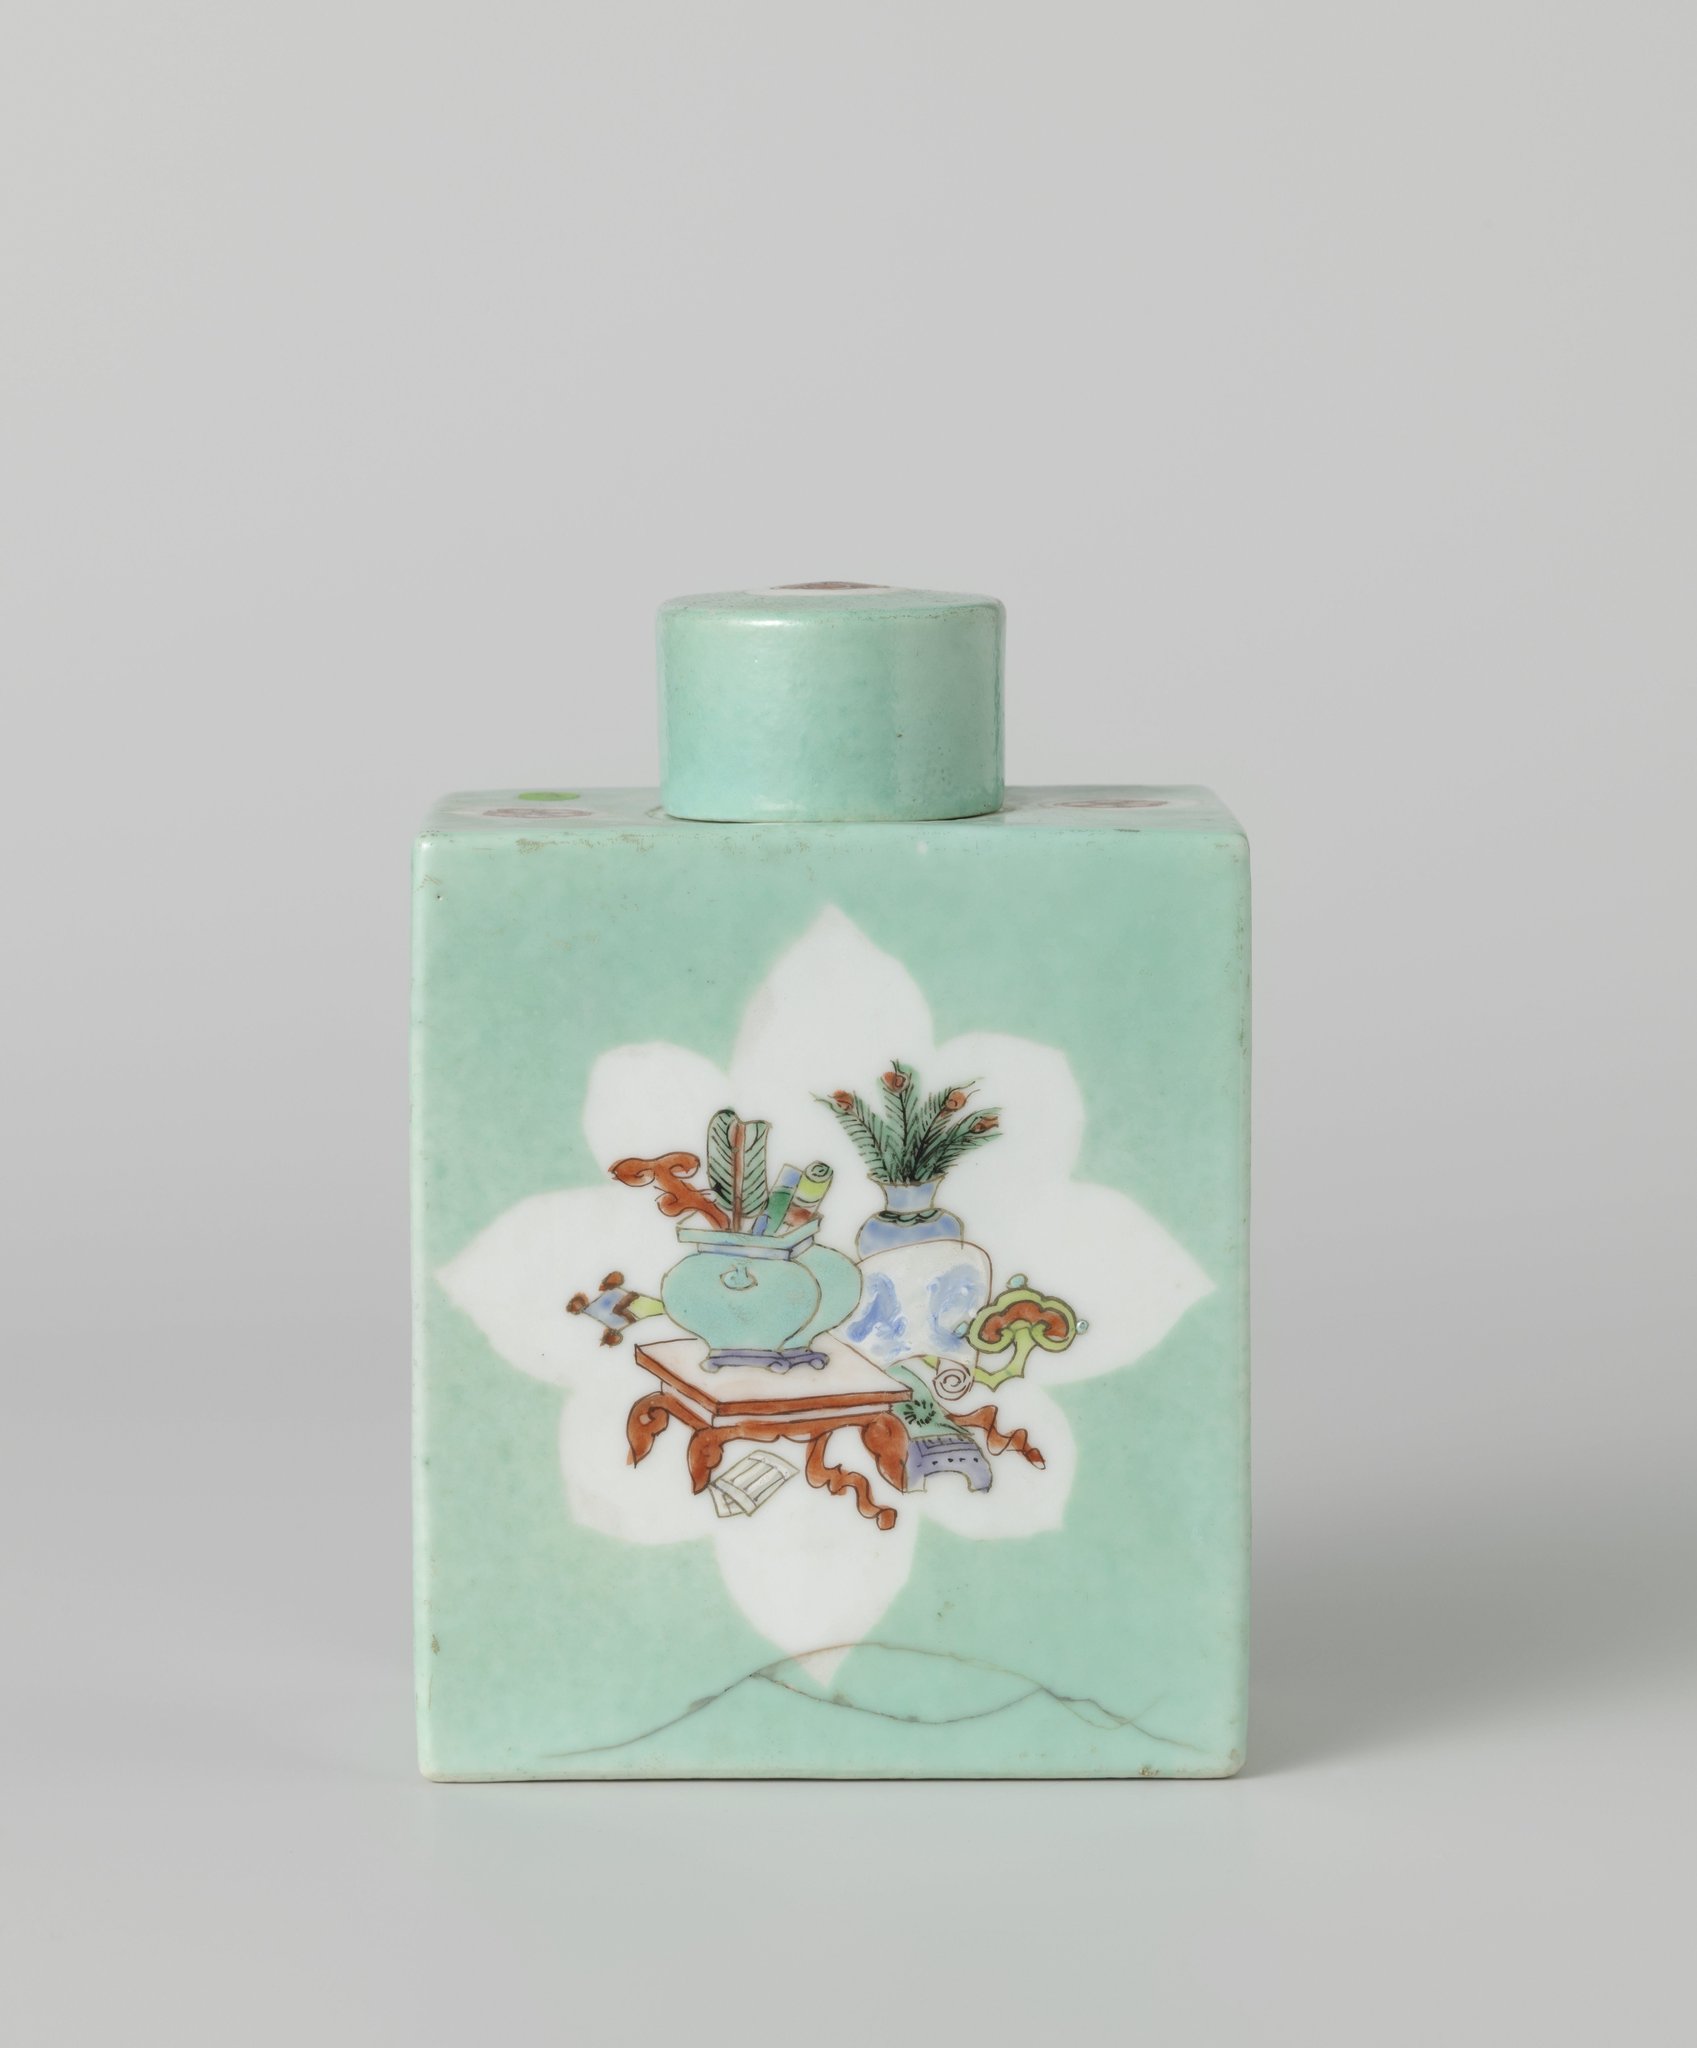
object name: lid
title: Rectangular tea caddy covered with a light blue glaze and antiquities in panels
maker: Anonymous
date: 1760-1770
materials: glaze, paint, porcelain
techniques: firing, turning, vitrification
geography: china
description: Deksel van rechthoekige theebus van porselein, bedekt met een lichtblauw/ turquoise glazuur en beschilderd op het glazuur in blauw, rood, groen, geel, paars en zwart. Op de bovenzijde een uitgespaard medaillon met gestileerde bloem afgebeeld. Europese vormen met emailkleuren.